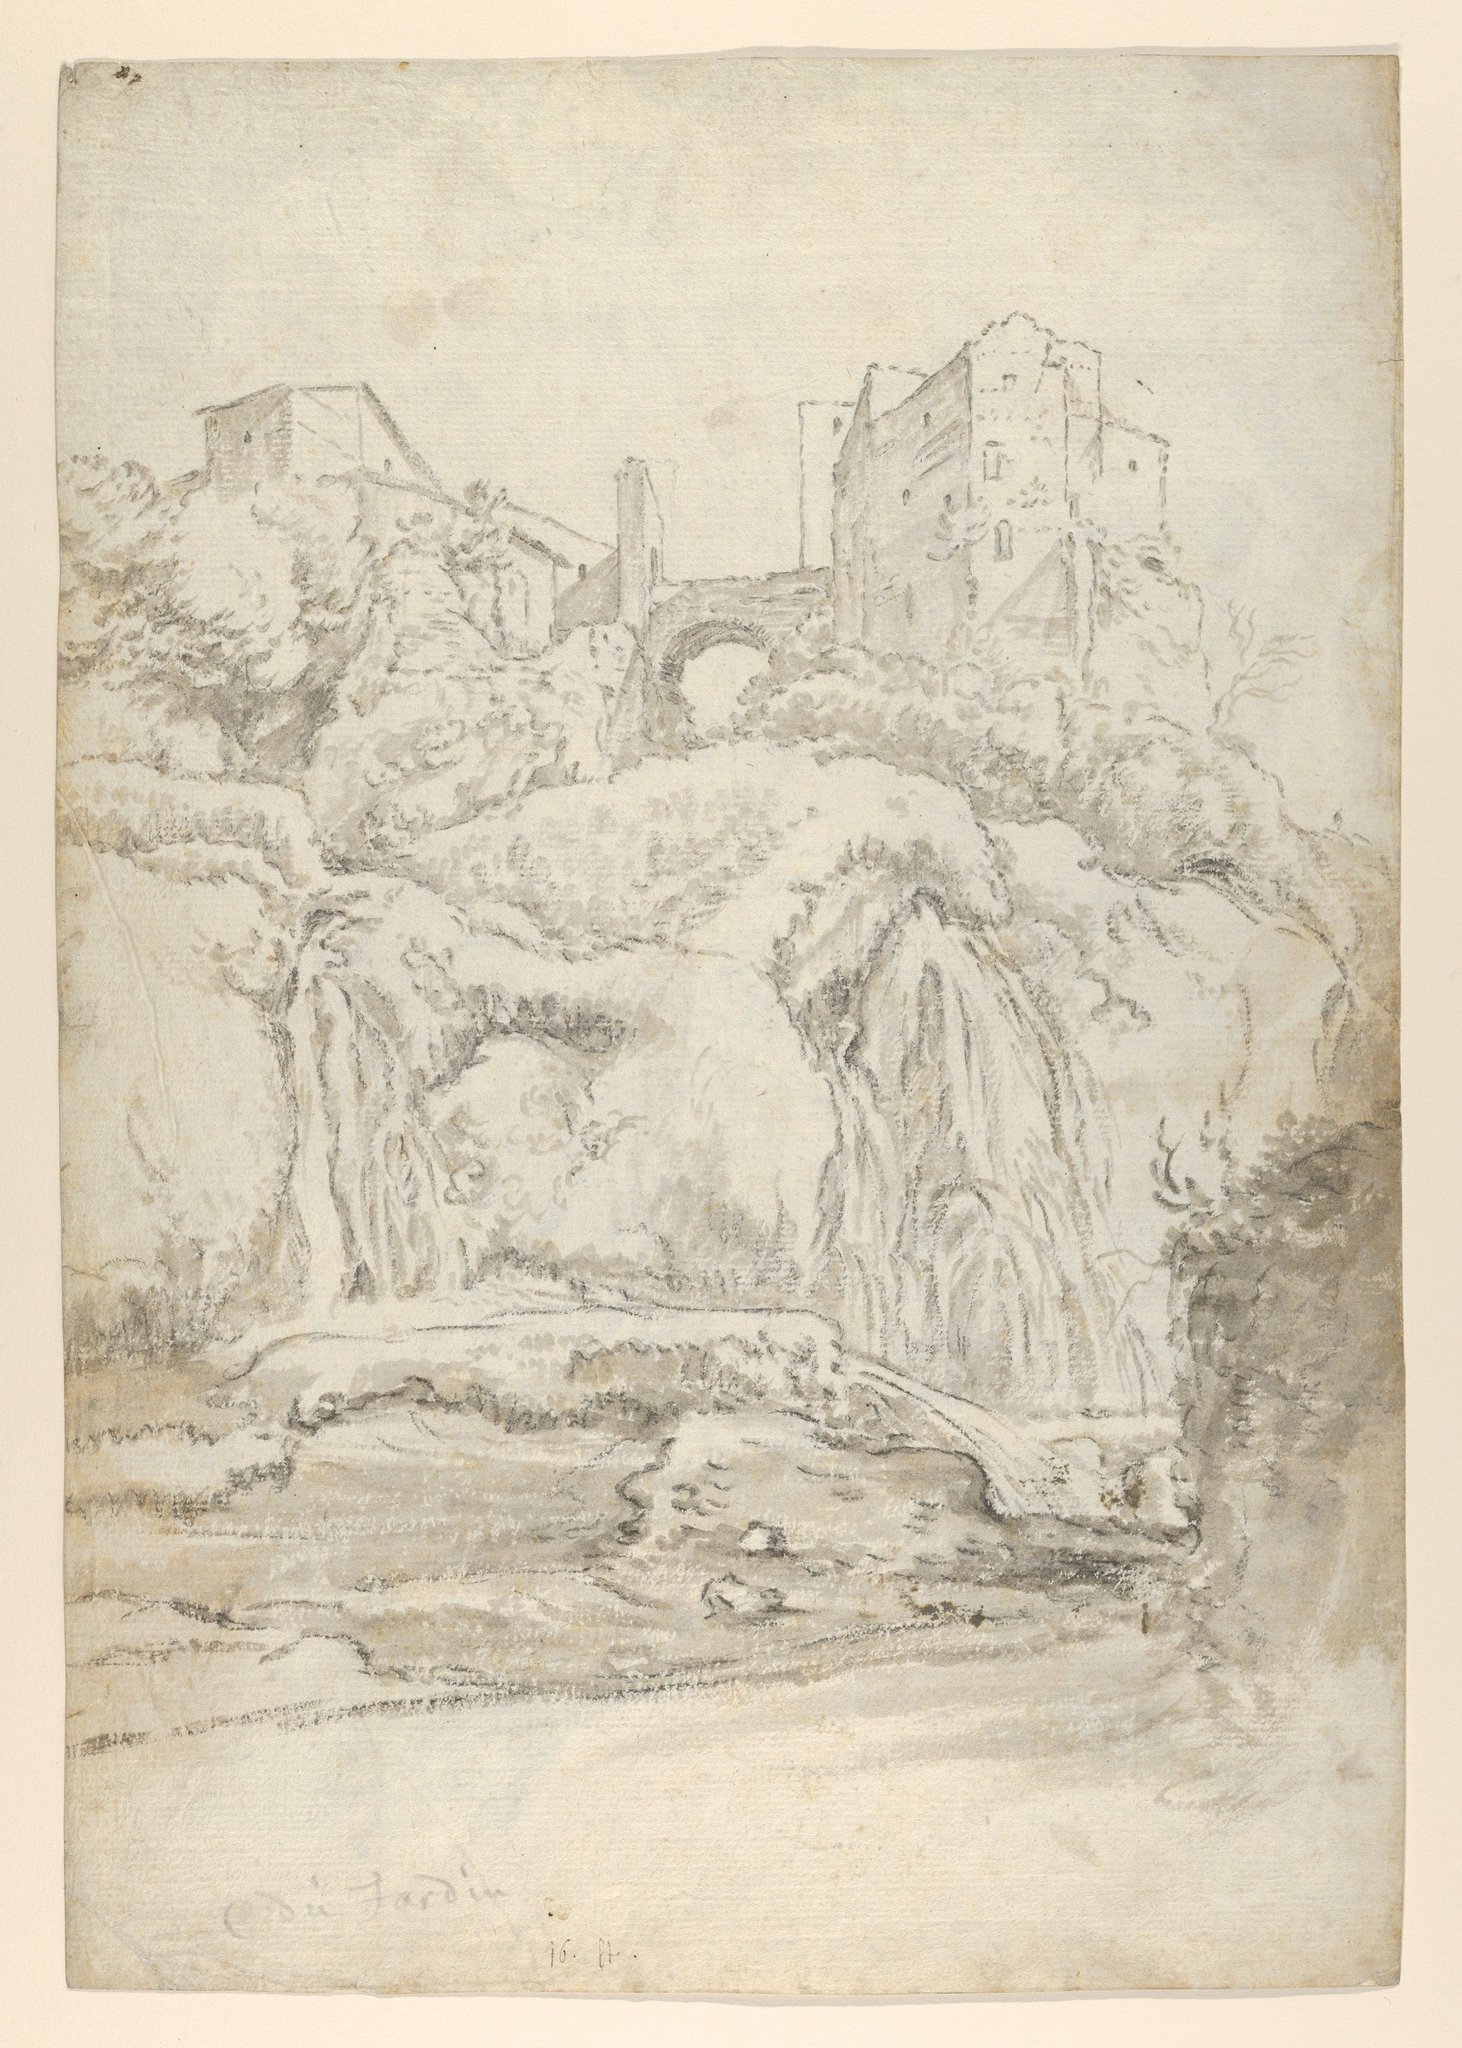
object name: drawing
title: View of a Bridge and Waterfalls in Tivoli (recto); View of a Waterfall in Tivoli From Within a Cave (verso)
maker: guilliam du gardijn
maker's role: artist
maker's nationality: dutch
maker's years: 1595-1647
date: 1640-1645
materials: chalk, ink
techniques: brush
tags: buildings,bridges,waterfalls